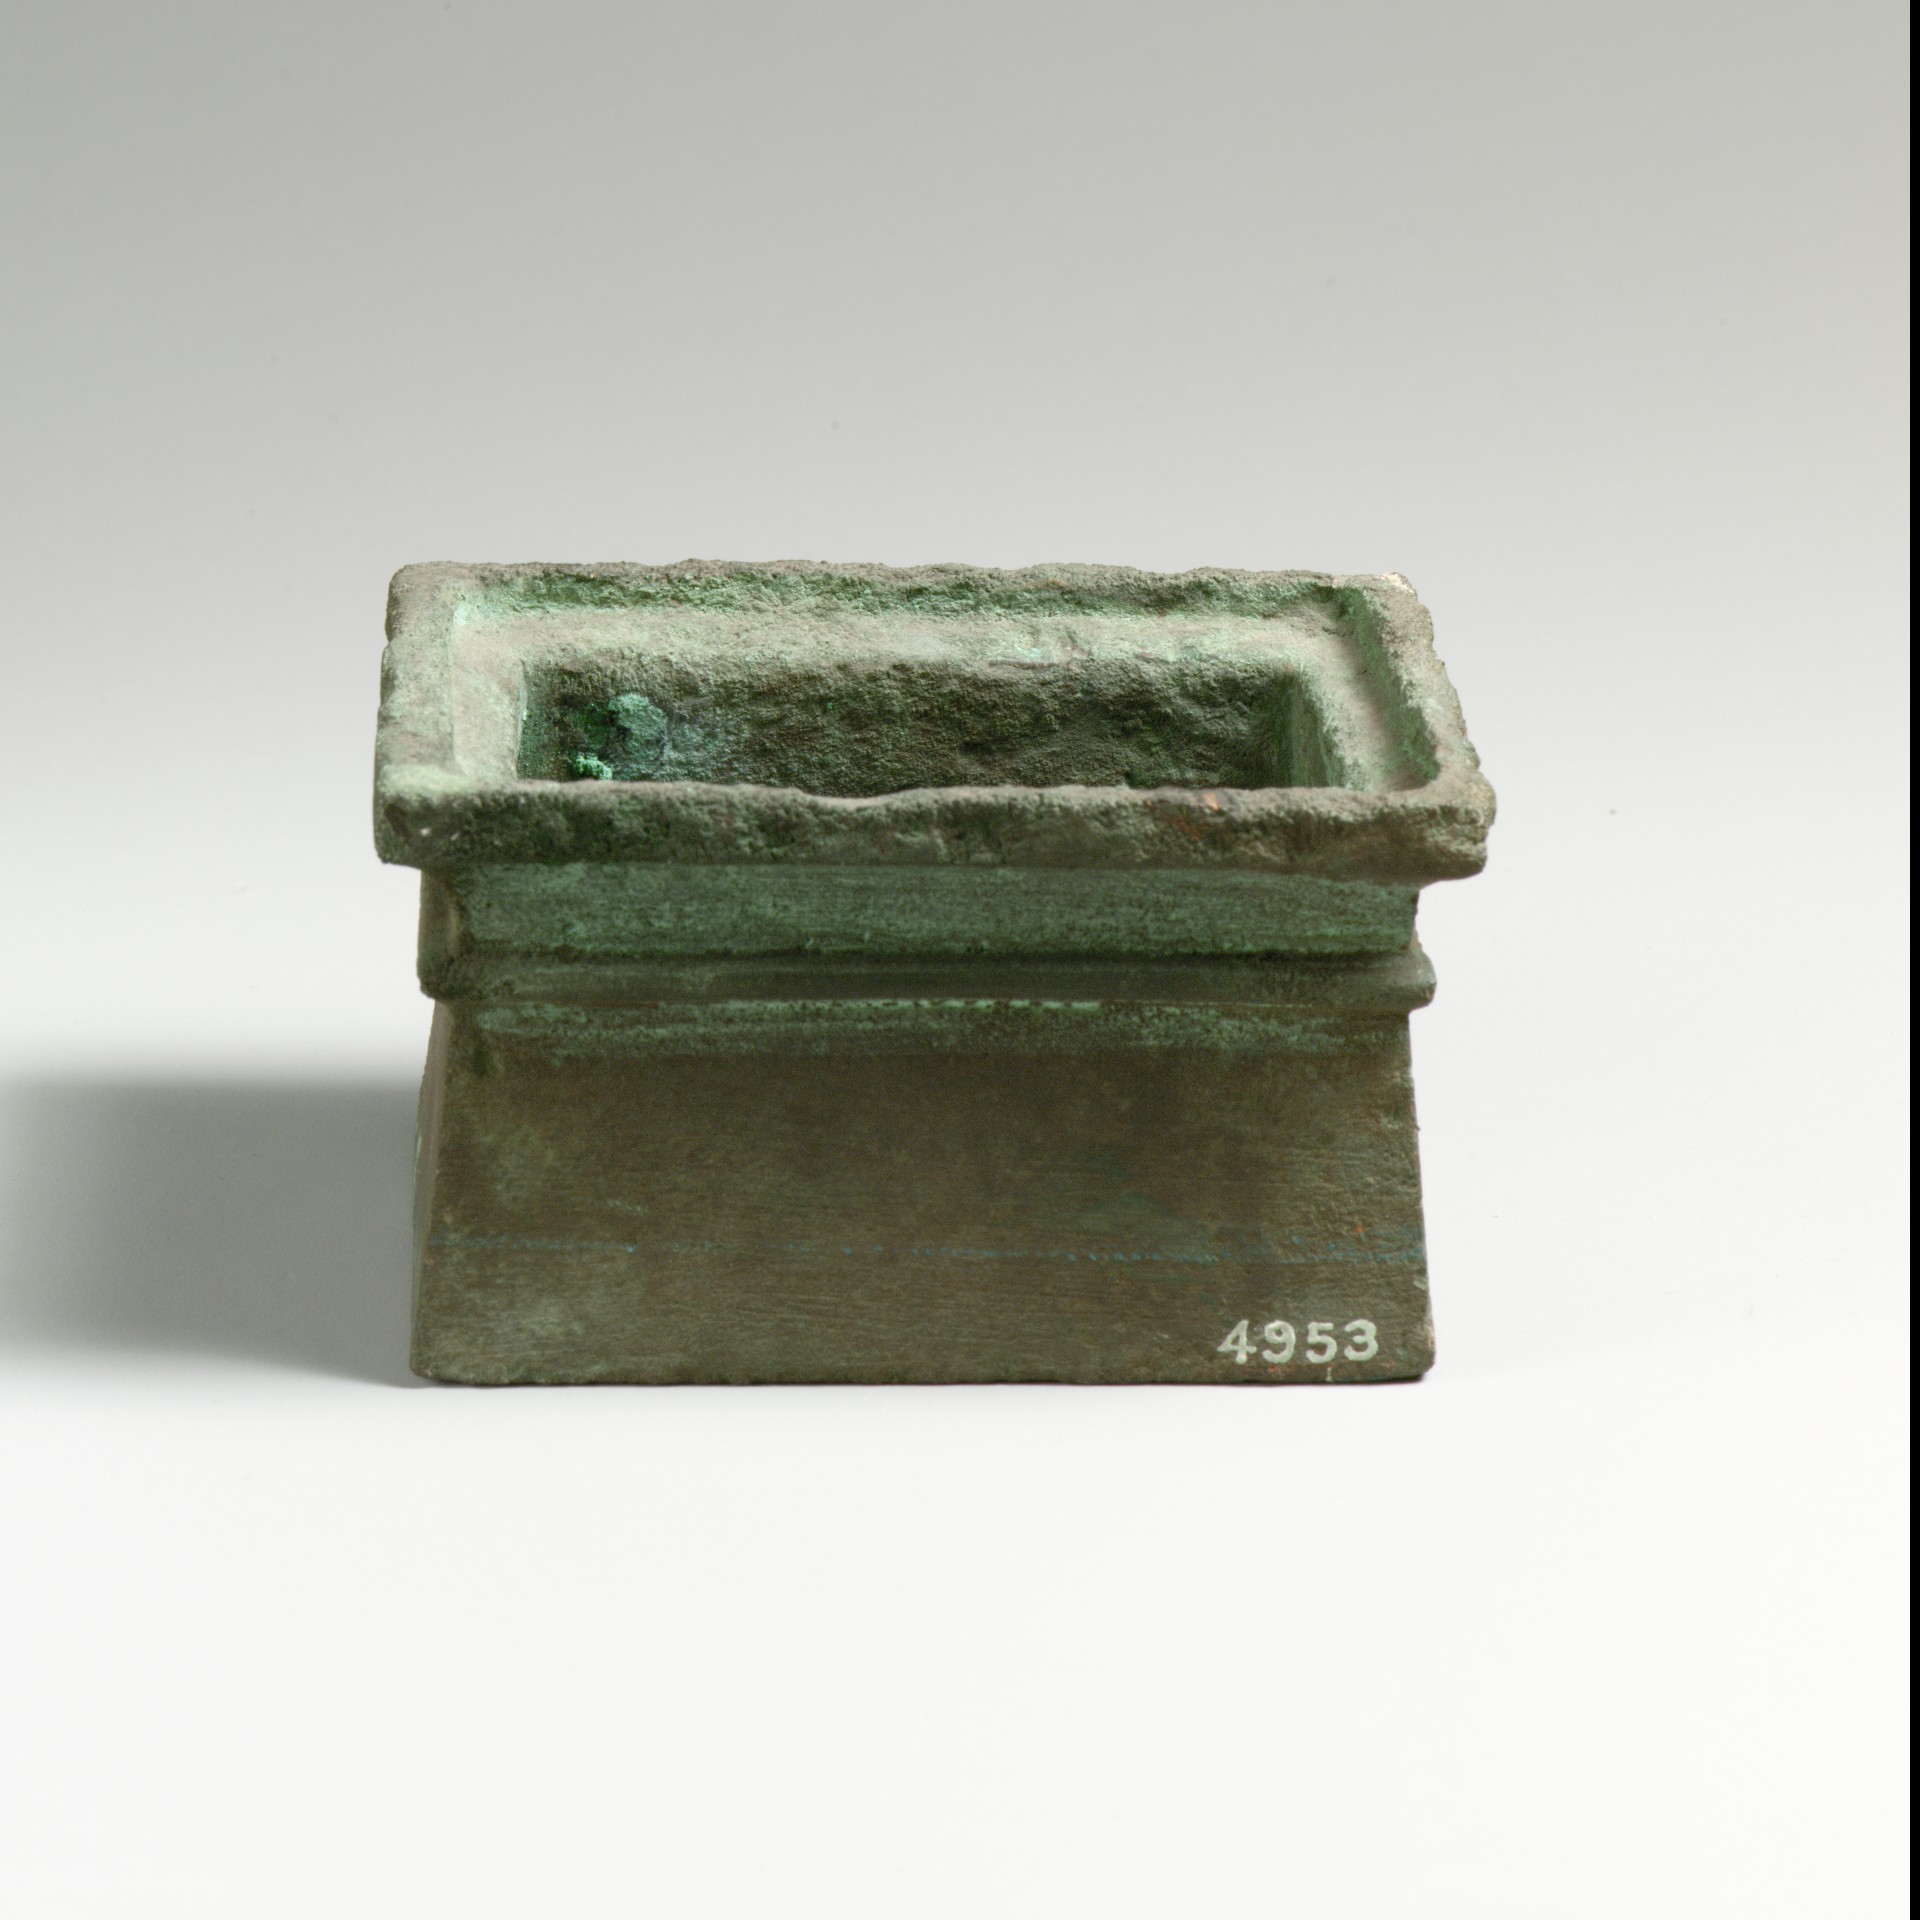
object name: box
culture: cypriot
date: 3900 BCE-100 CE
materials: bronze